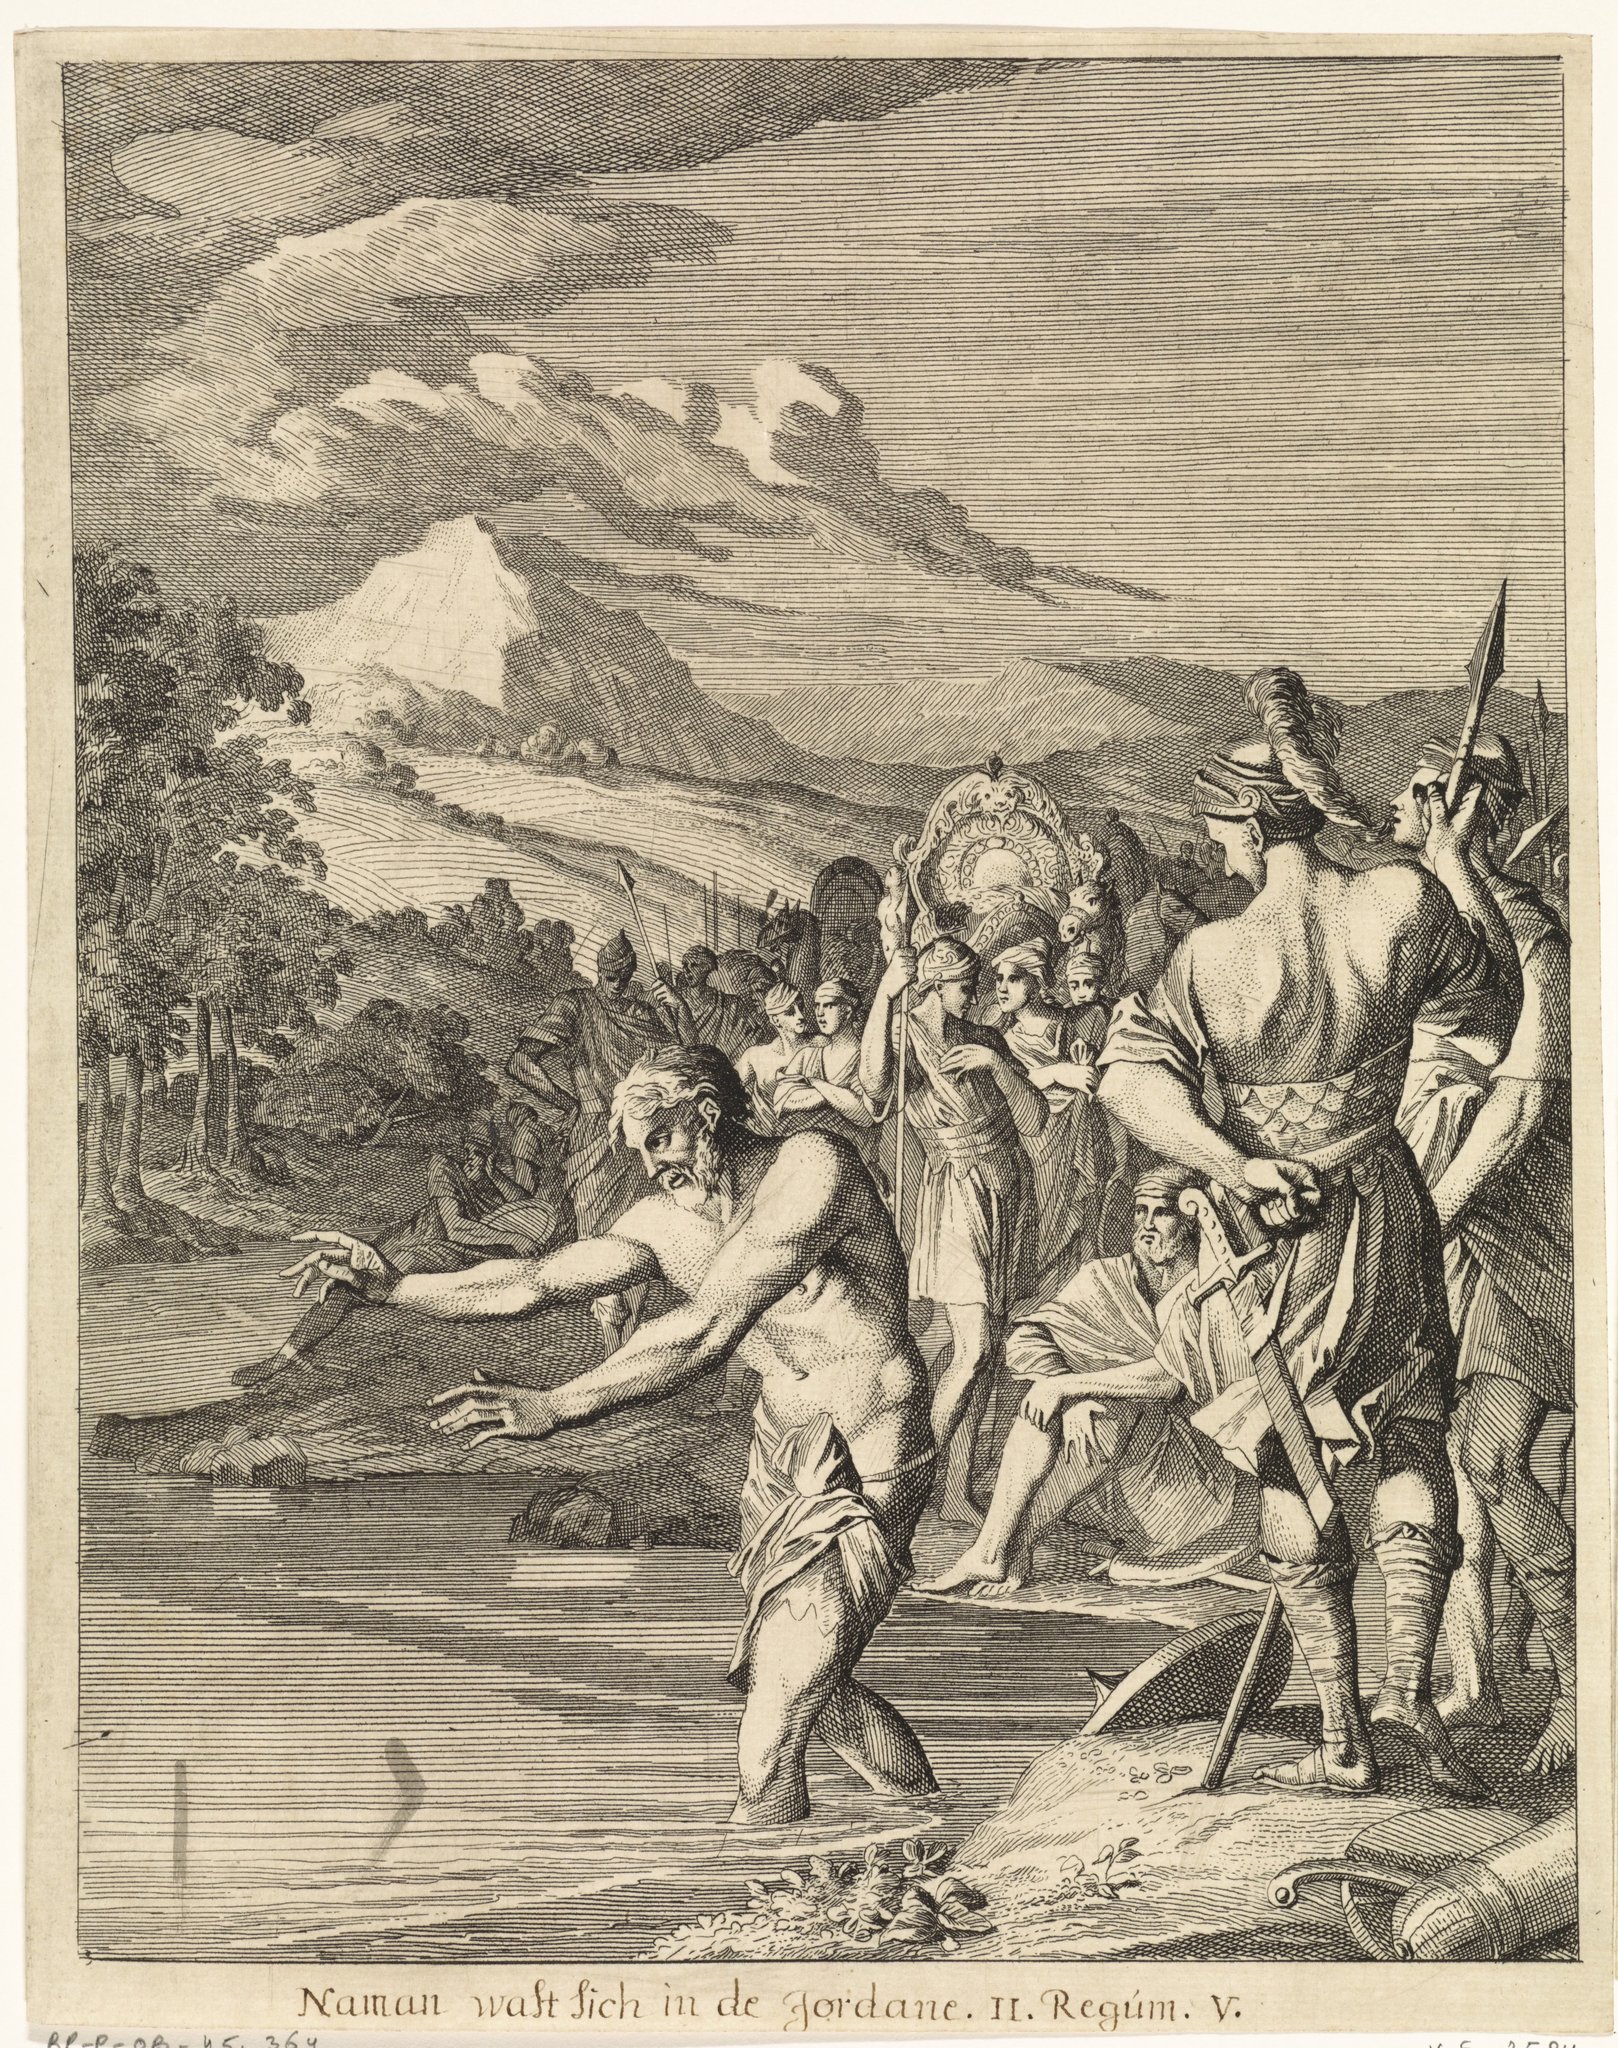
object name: print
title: Genezing van Naäman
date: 1708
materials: paper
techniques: etching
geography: amsterdam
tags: naaman comes to the jordan, dips himself seven times and is cured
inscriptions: collector's mark: Lugt 2228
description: Proefdruk van een prent welke is opgenomen als illustratie in: Historiae Celebriores Veteris Testamenti. Christoph Weigel, 1708.